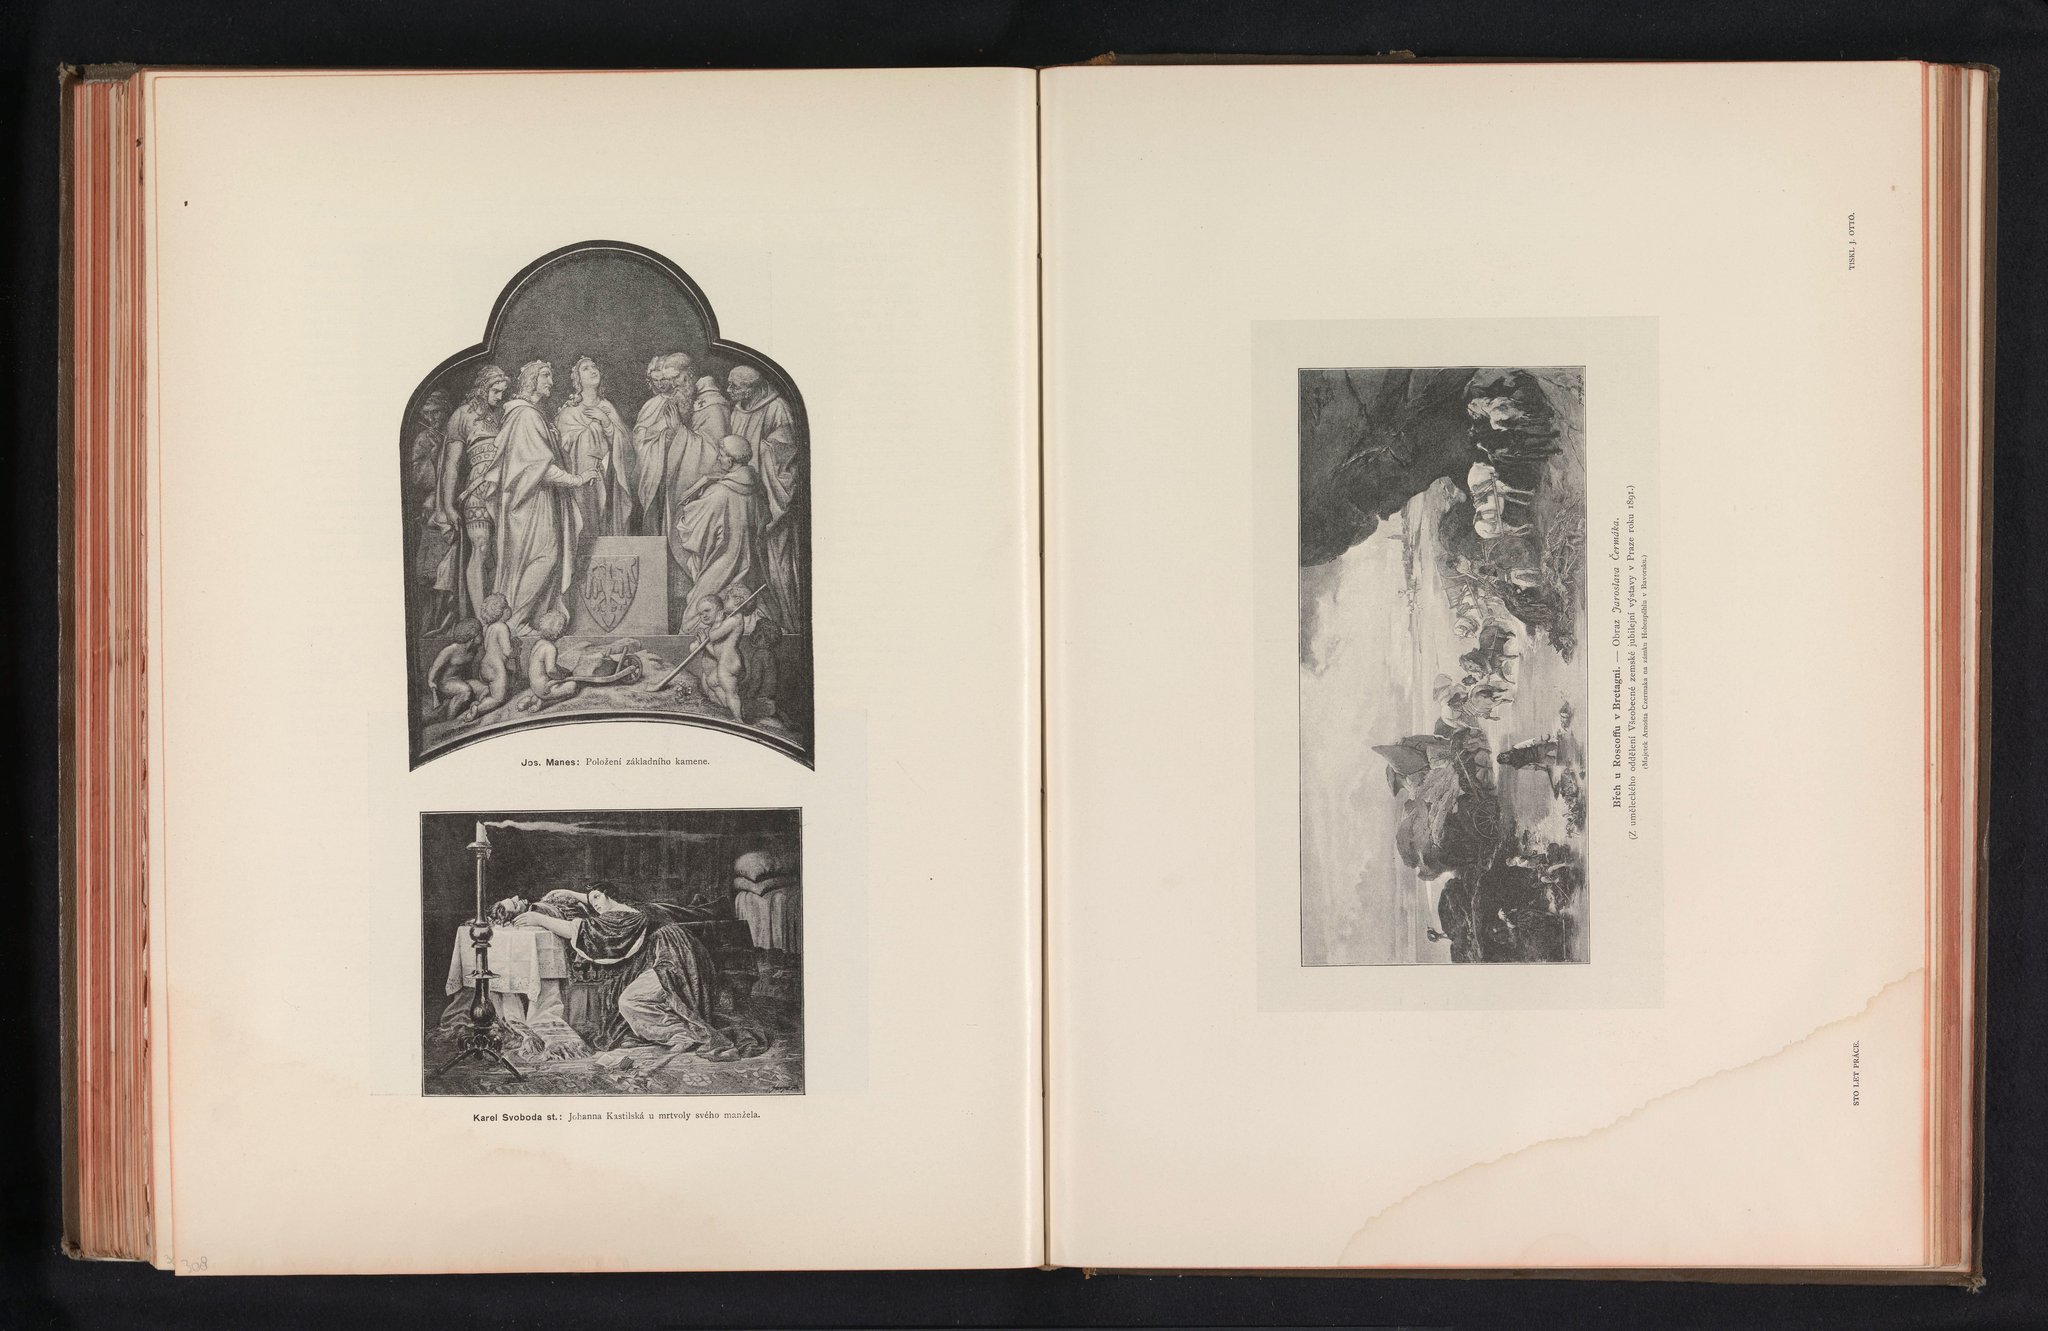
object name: page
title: Breh u Roscoffu v Bretagni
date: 1891-1895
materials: paper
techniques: autotype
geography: prague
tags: four-wheeled, animal-drawn vehicle, e.g.: cab, carriage, coach, rocky coast